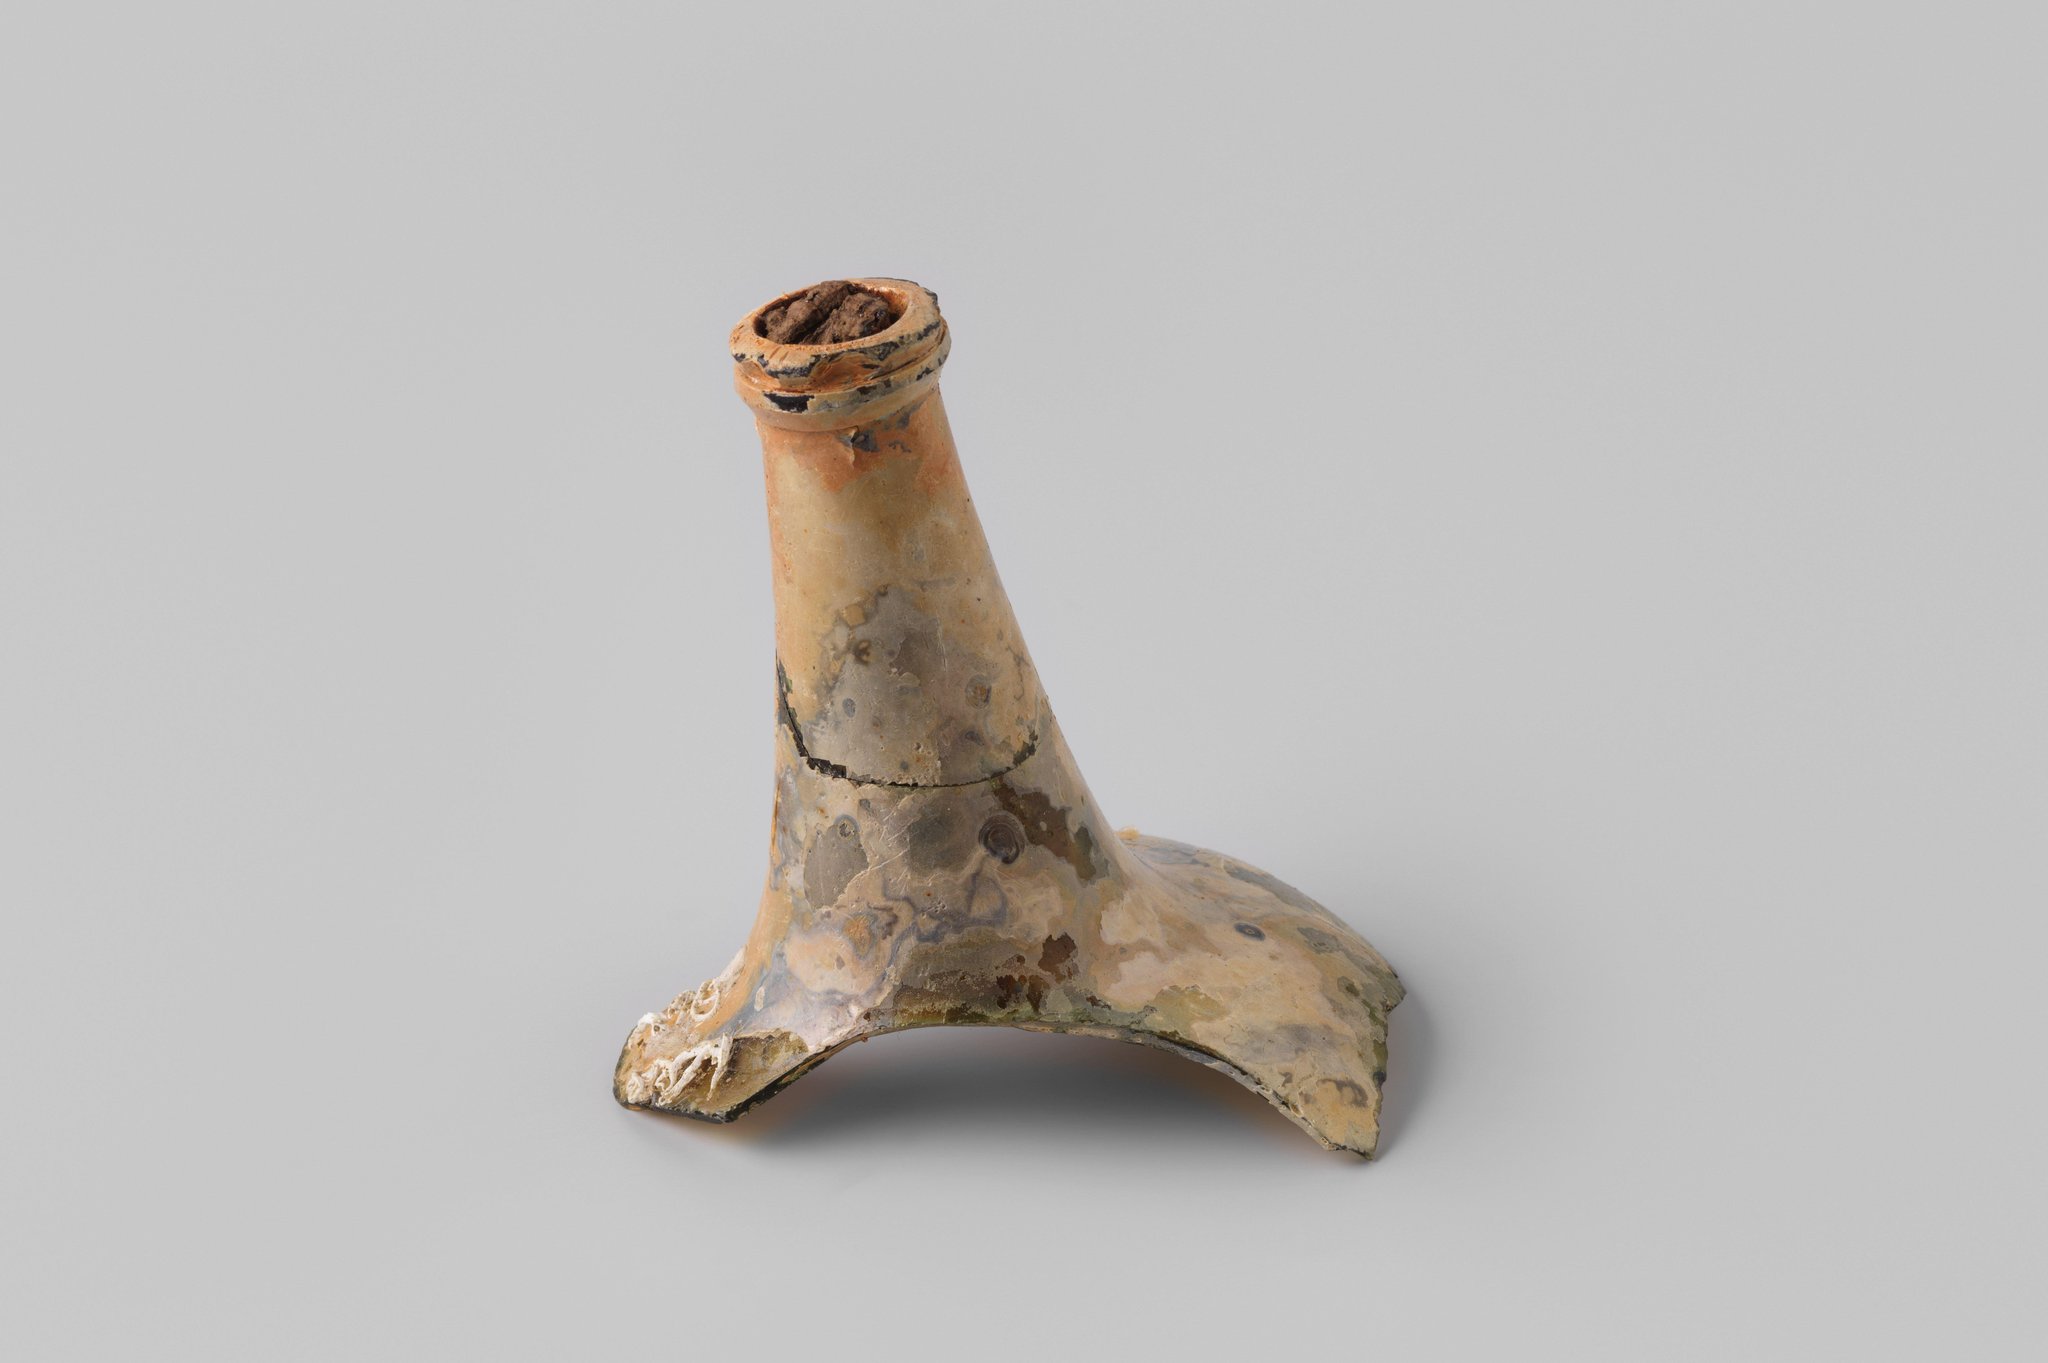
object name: neck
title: Hals met kurk van een wijnfles uit het wrak van de Oost-Indiëvaarder Hollandia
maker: Anonymous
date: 1700-1743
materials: cork, glass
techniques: green glass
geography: netherlands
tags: verenigde oostindische compagnie, hollandia (schip), annet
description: Wine bottle, continental production, neck, onion-shaped bottle or bottle with vertical side; eroded, vs-string rim, cork level with mouth.